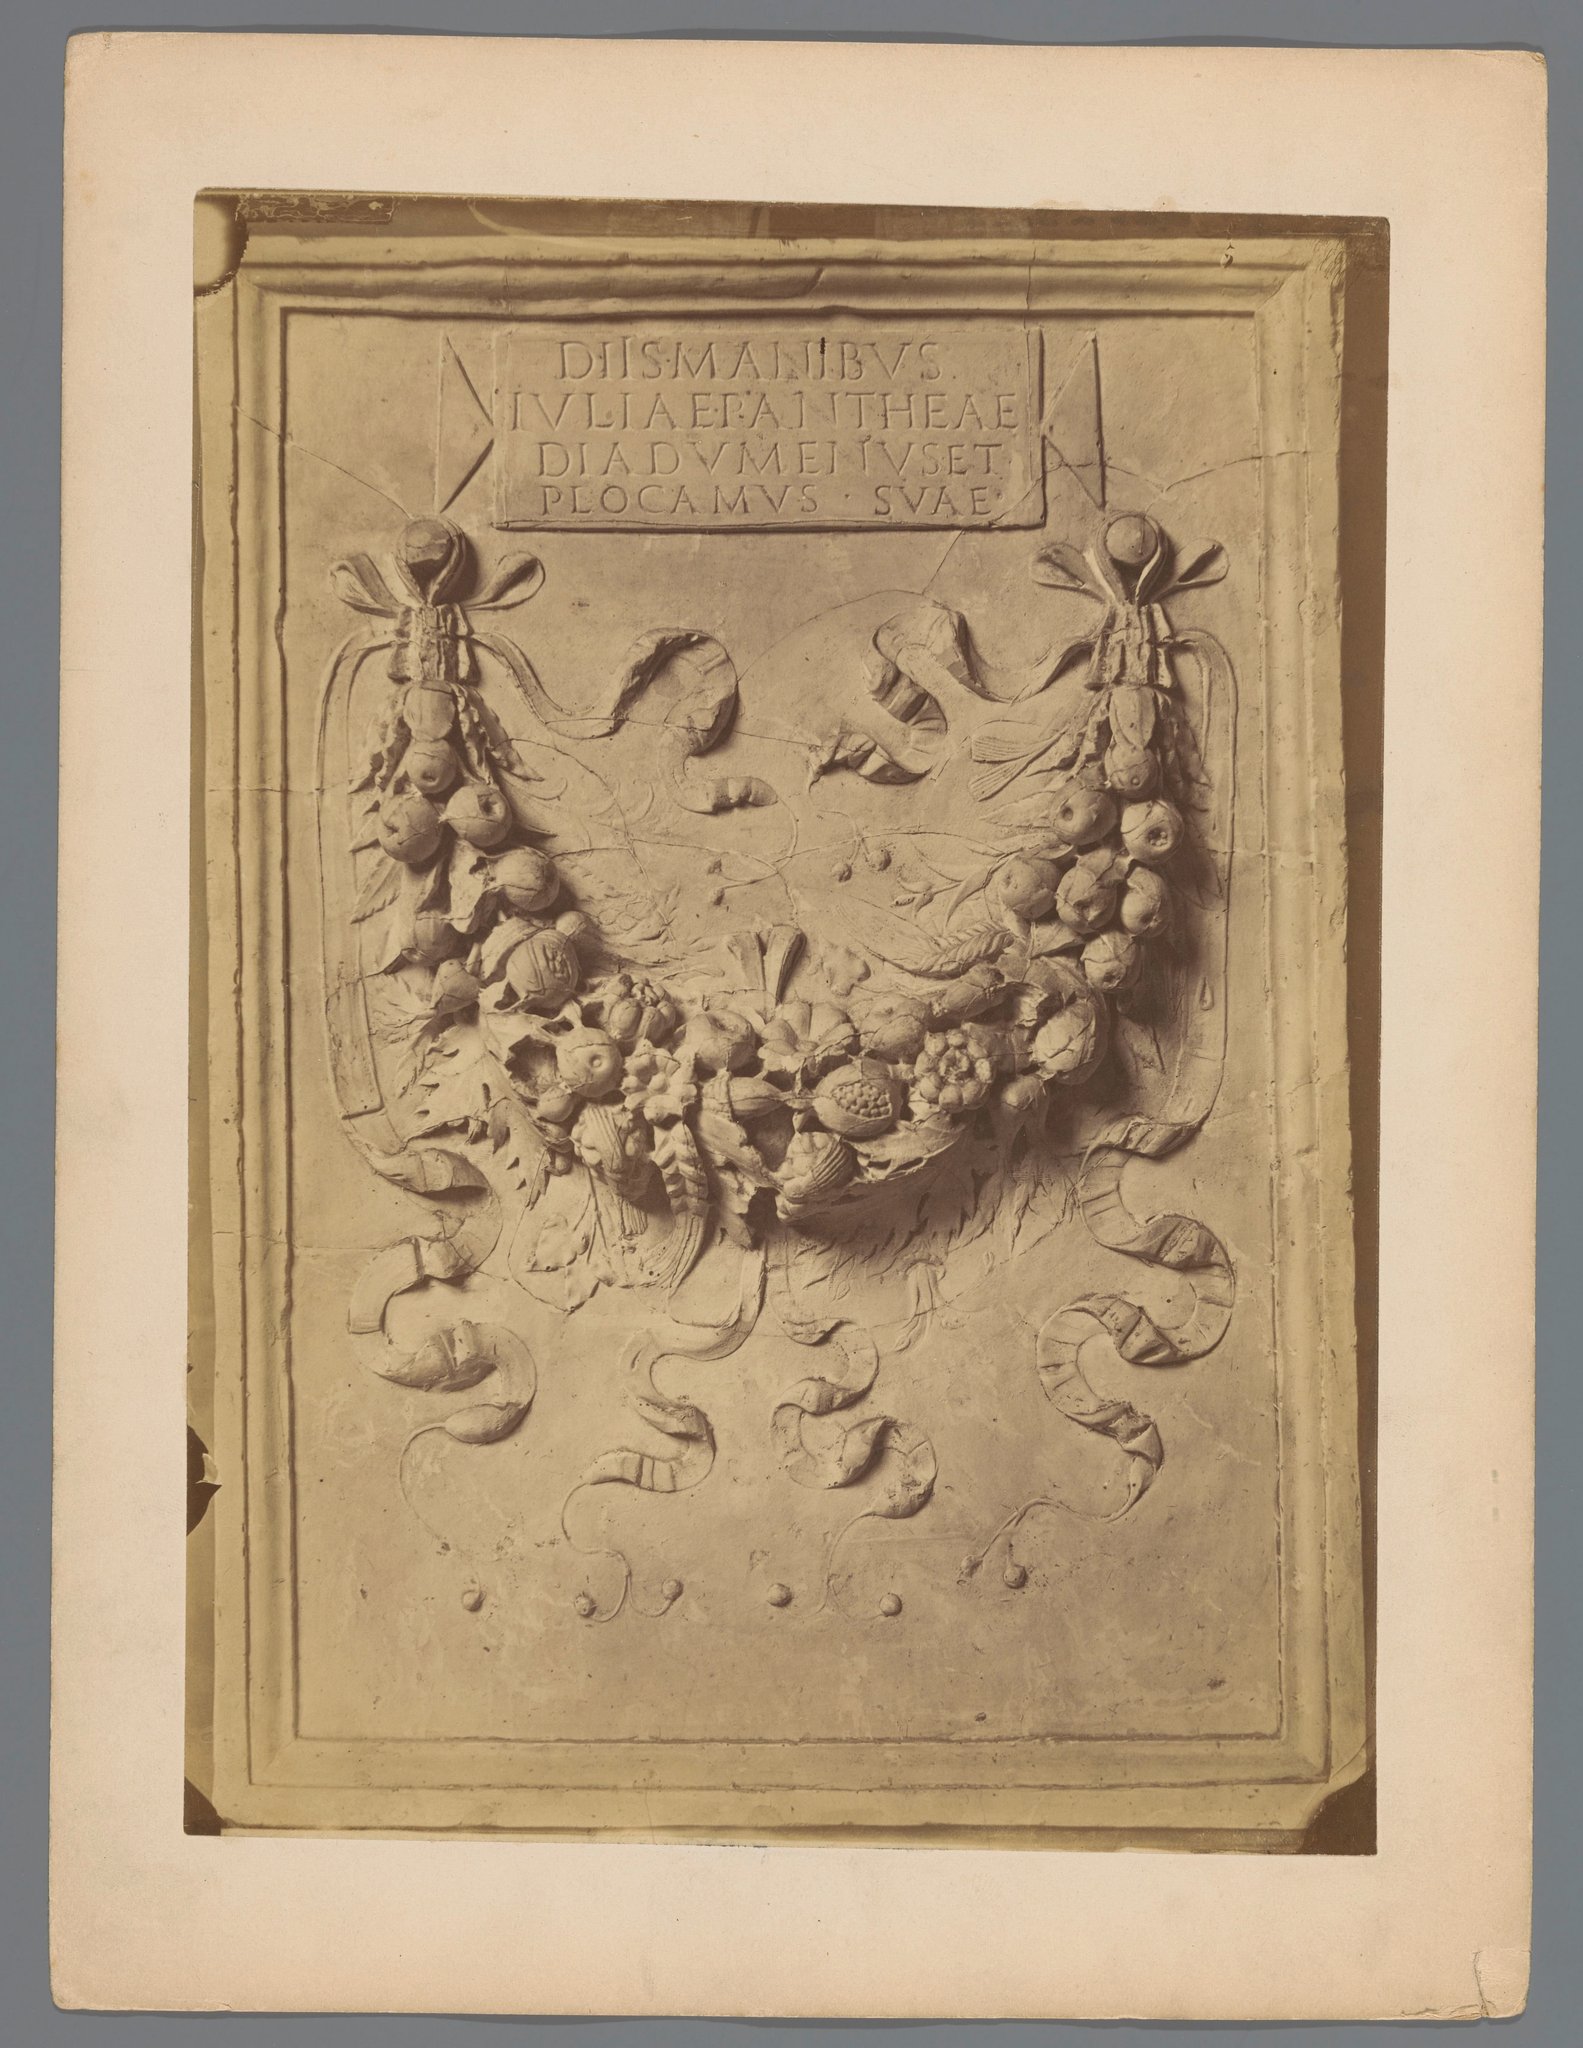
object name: photograph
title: Reliëf met een guirlande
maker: Anonymous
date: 1875-1900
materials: cardboard, photographic support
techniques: albumen print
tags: fruits and vegetables ~ ornament, ornament ~ festoon, garland, sculpture (+ relief ~ sculpture)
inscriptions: inscription: ‘Stijlkast pl 16’, collector's mark: Lugt 3937